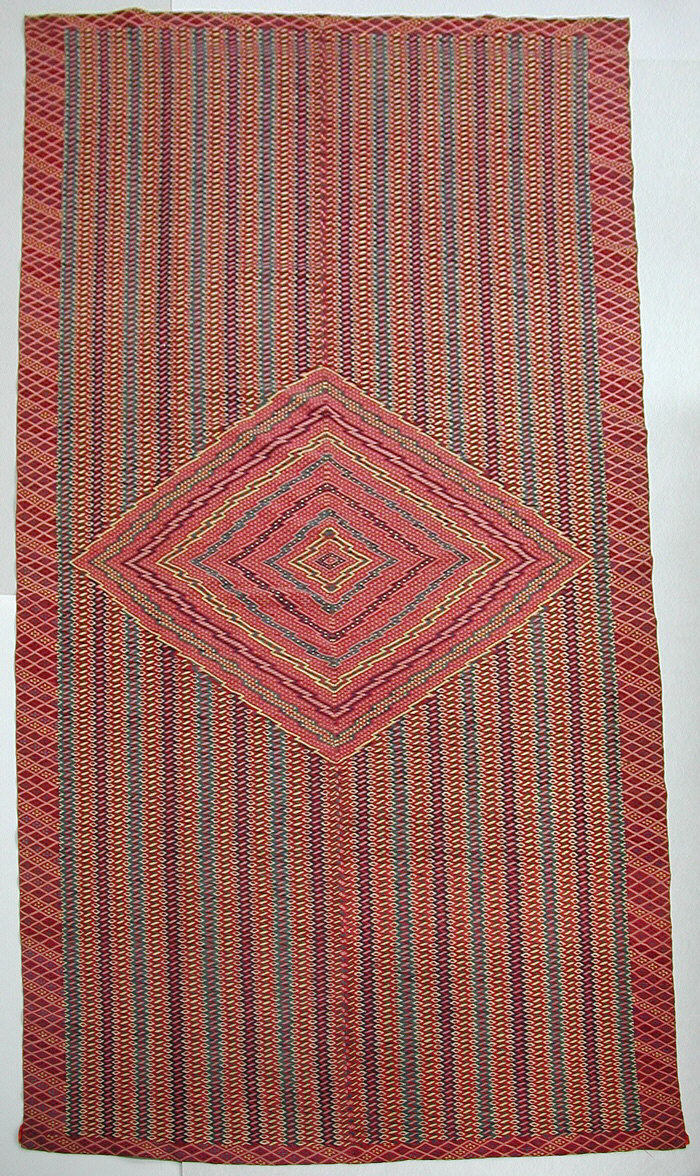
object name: serape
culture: saltillo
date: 1800-1850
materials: cotton, wool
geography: mexico